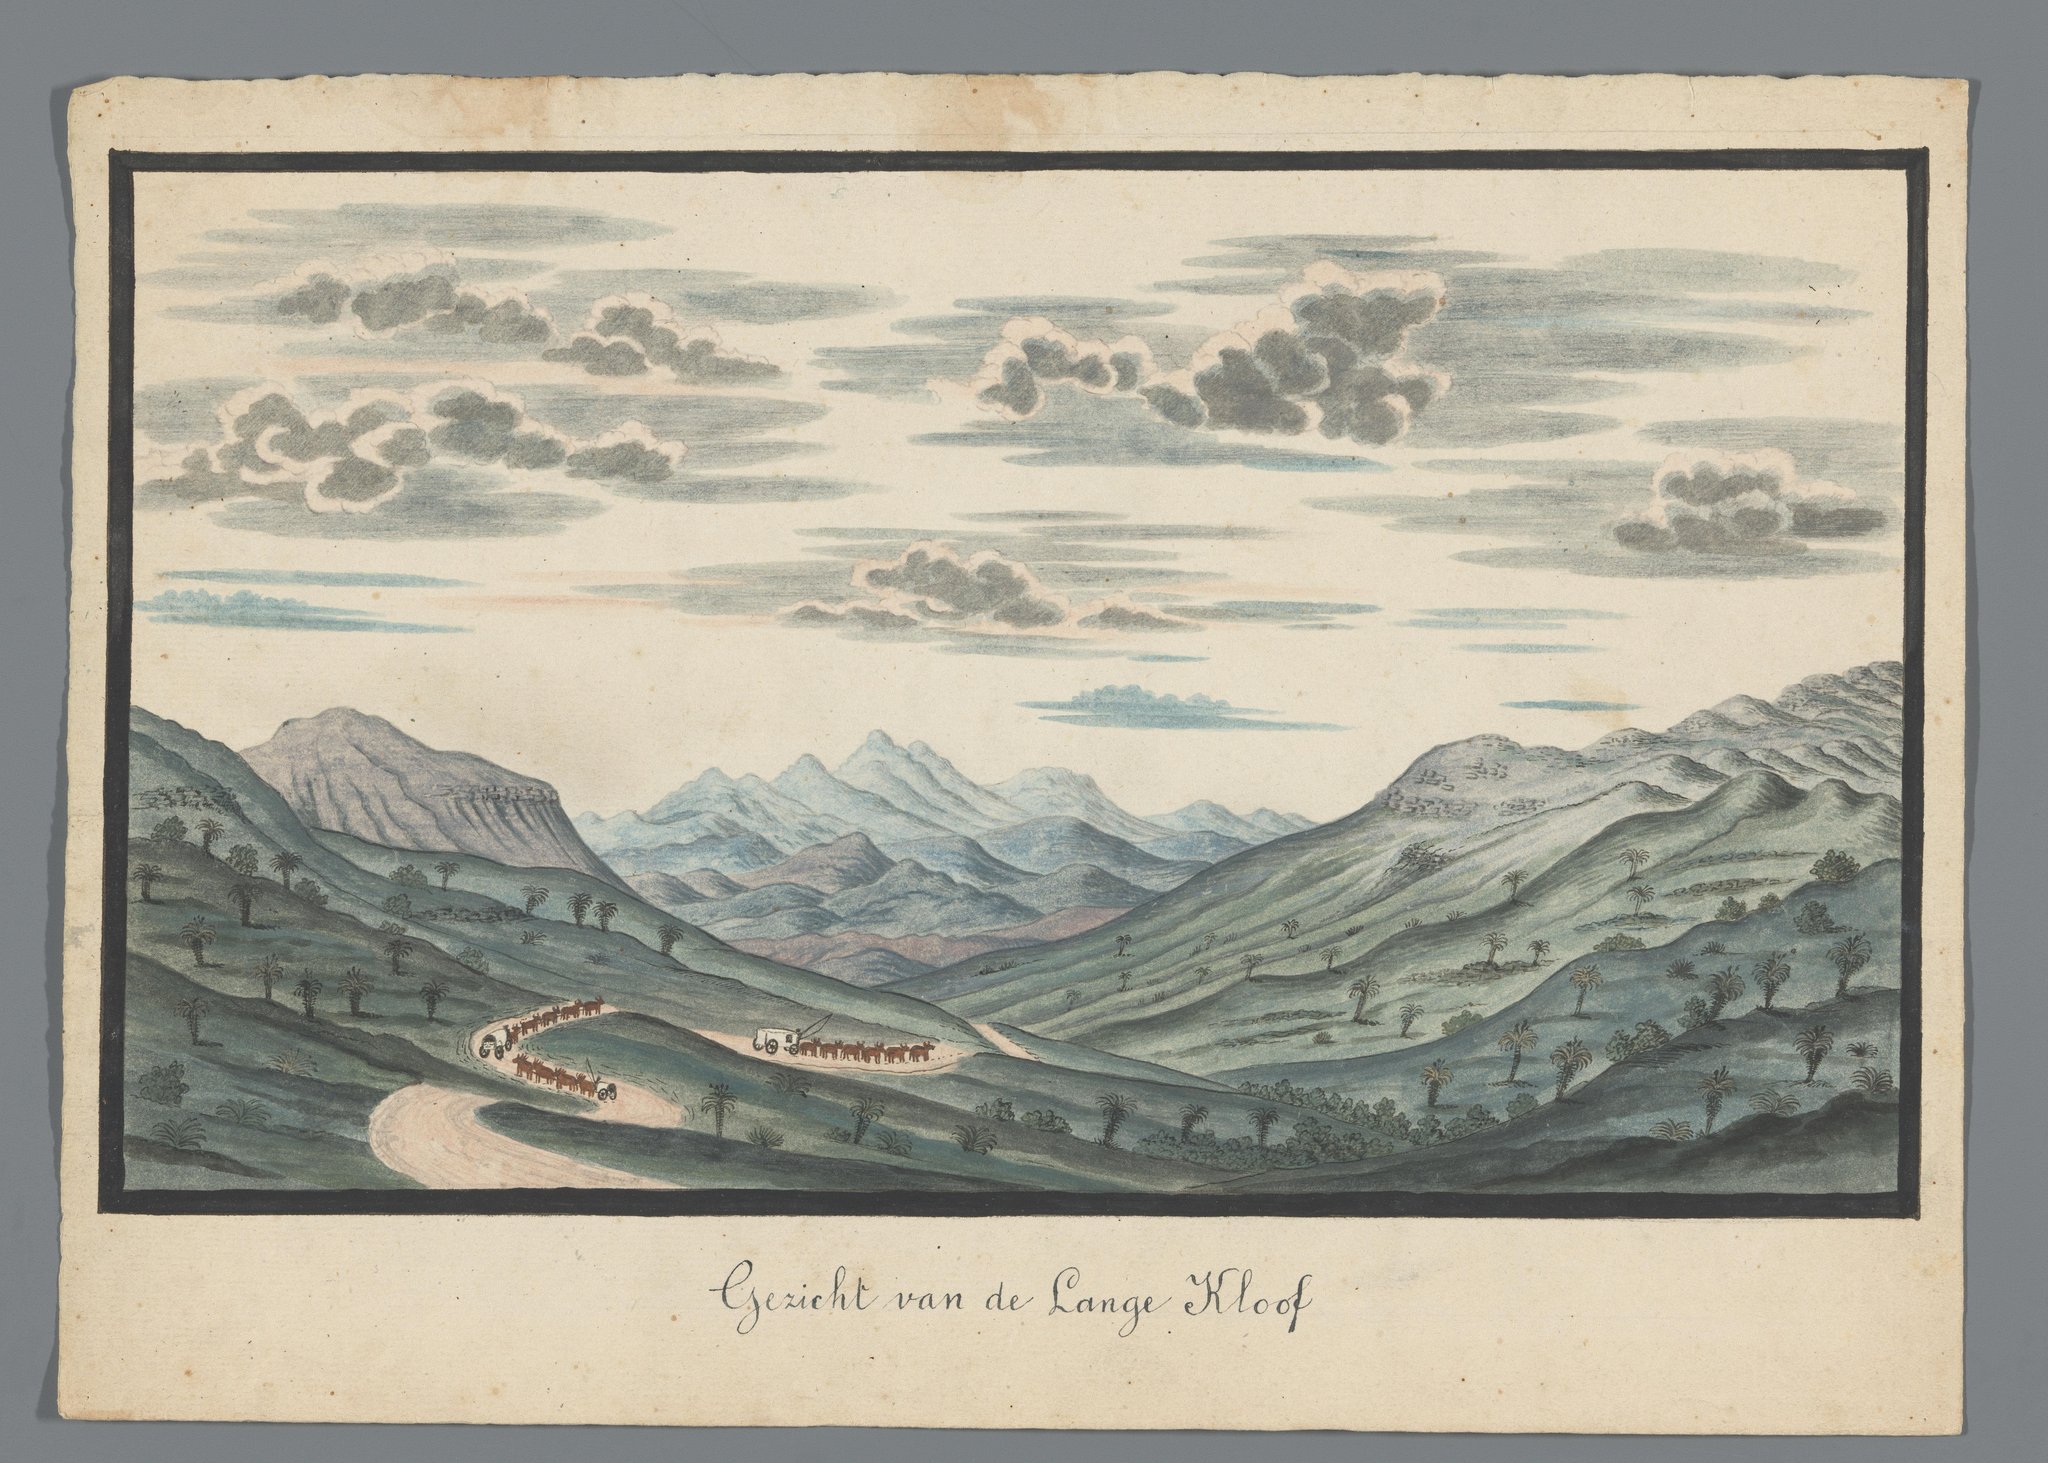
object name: drawing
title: Gezicht op Langkloof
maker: johannes schumacher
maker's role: draughtsman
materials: paper, watercolor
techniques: brush, pen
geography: south africa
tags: covered wagon, hooded wagon, mountain-range, snow peaks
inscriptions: label: ‘8’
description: Gezicht op Langkloof, een pas tussen de bergen. Over een weg gaan drie ossenwagens. Tekening gemaakt tijdens de tweede reis van Hendrik Swellengrebel, naar het noordoosten van de Kaapkolonie, 10 september - 26 december 1776.